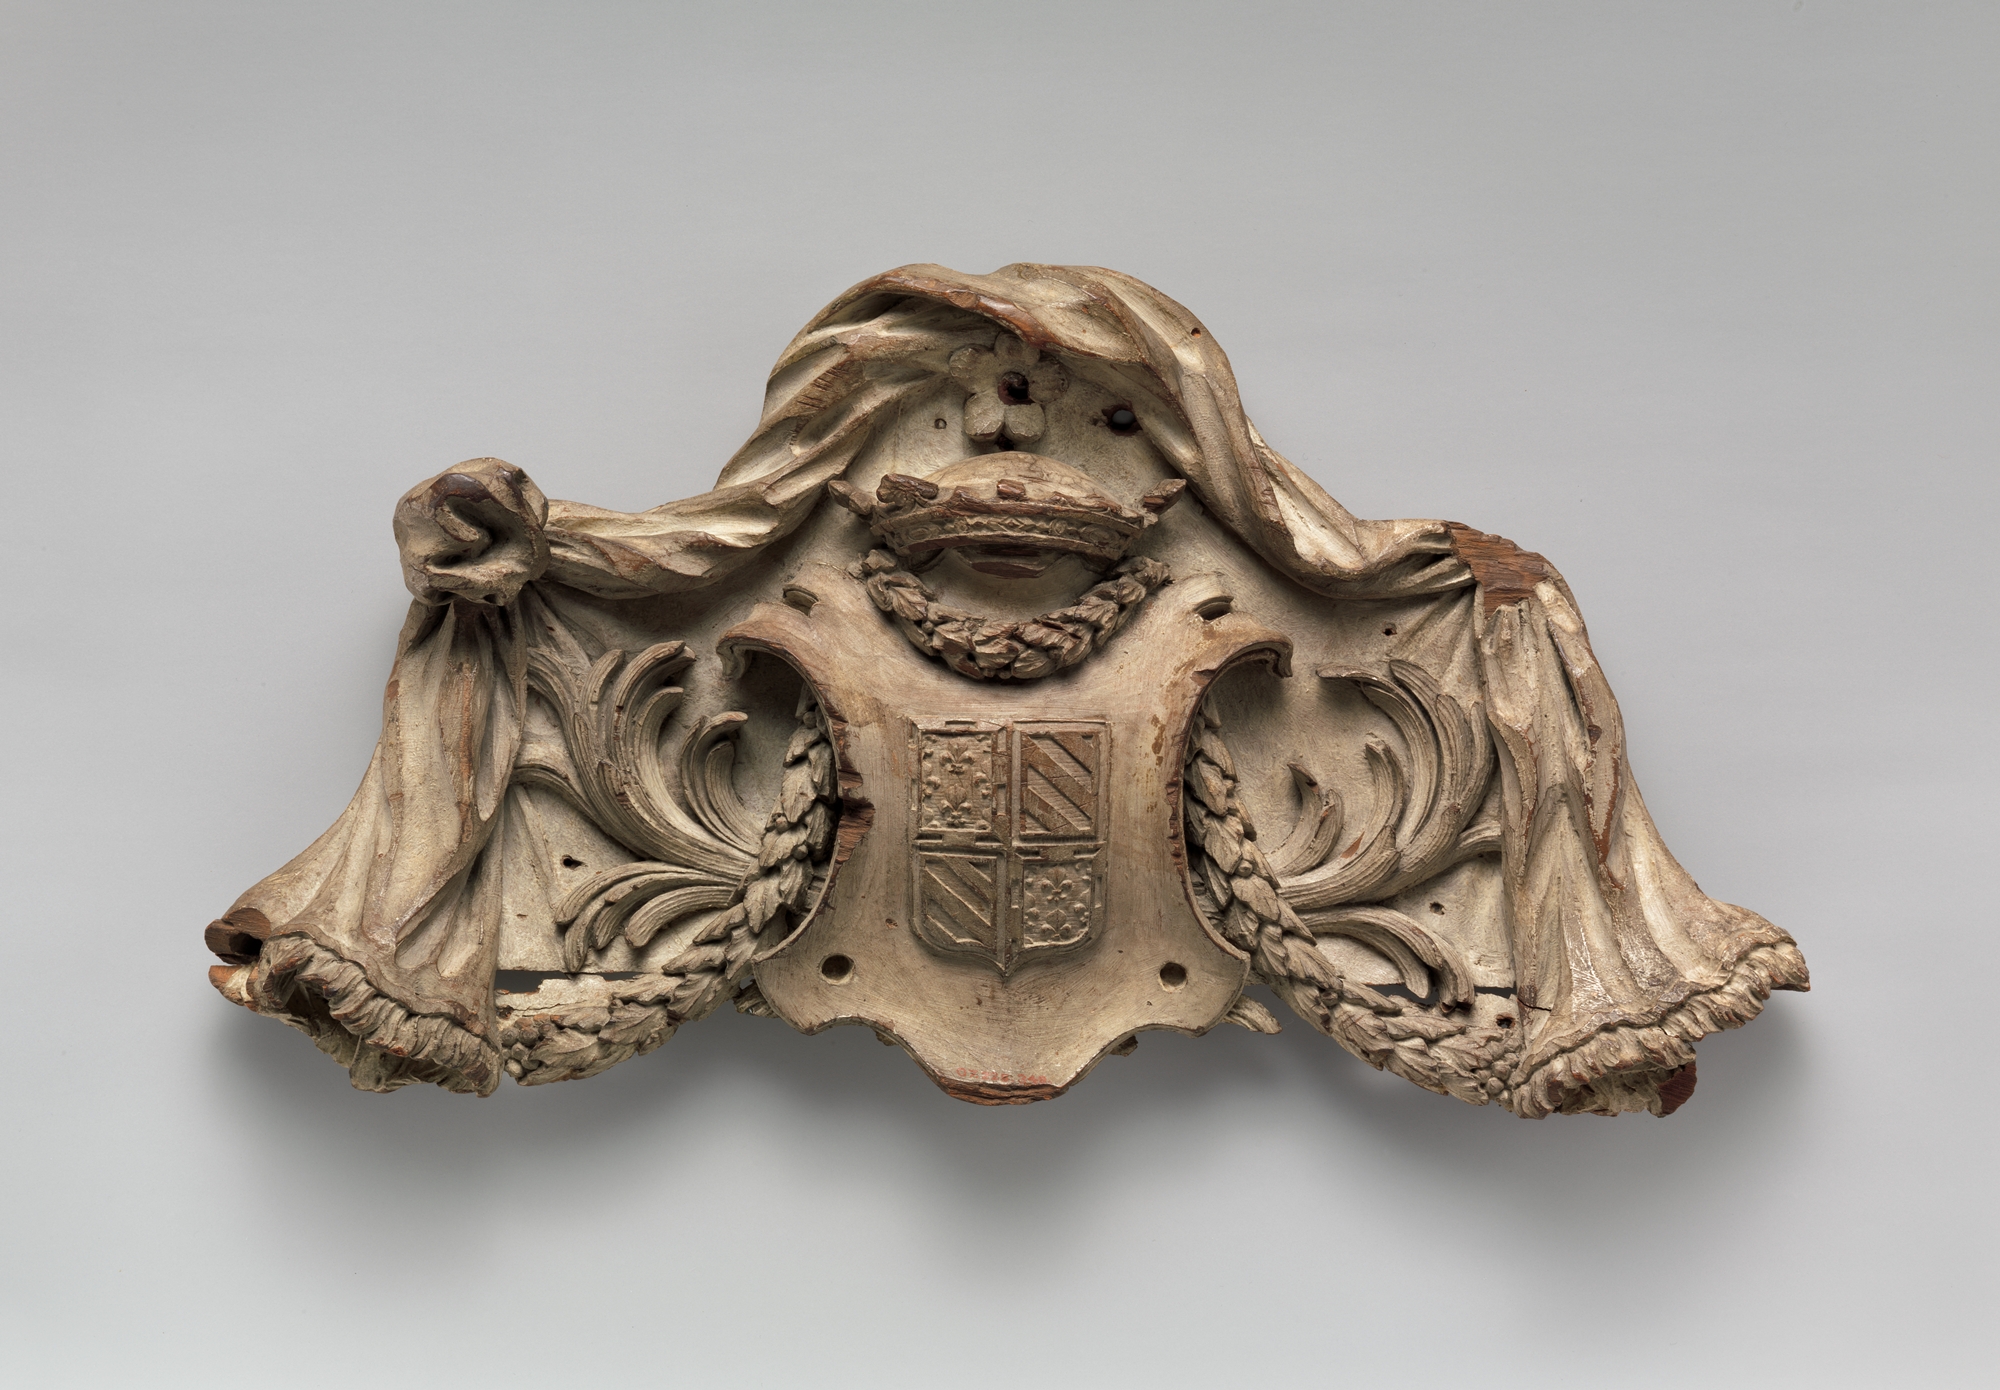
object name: cartouche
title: Cartouche fragment from a frame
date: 1701-1800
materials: wood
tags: coat of arms